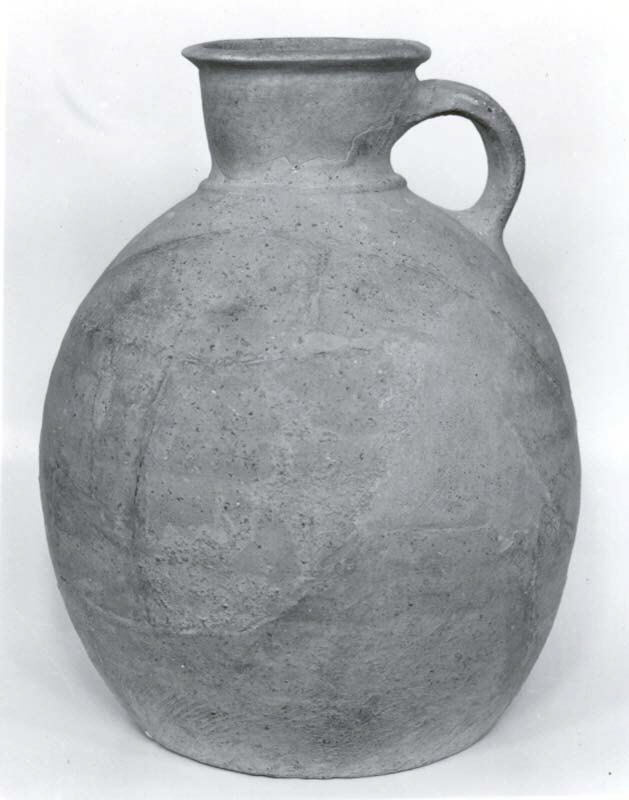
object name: jug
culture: sasanian or islamic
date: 501-800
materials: ceramic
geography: iran